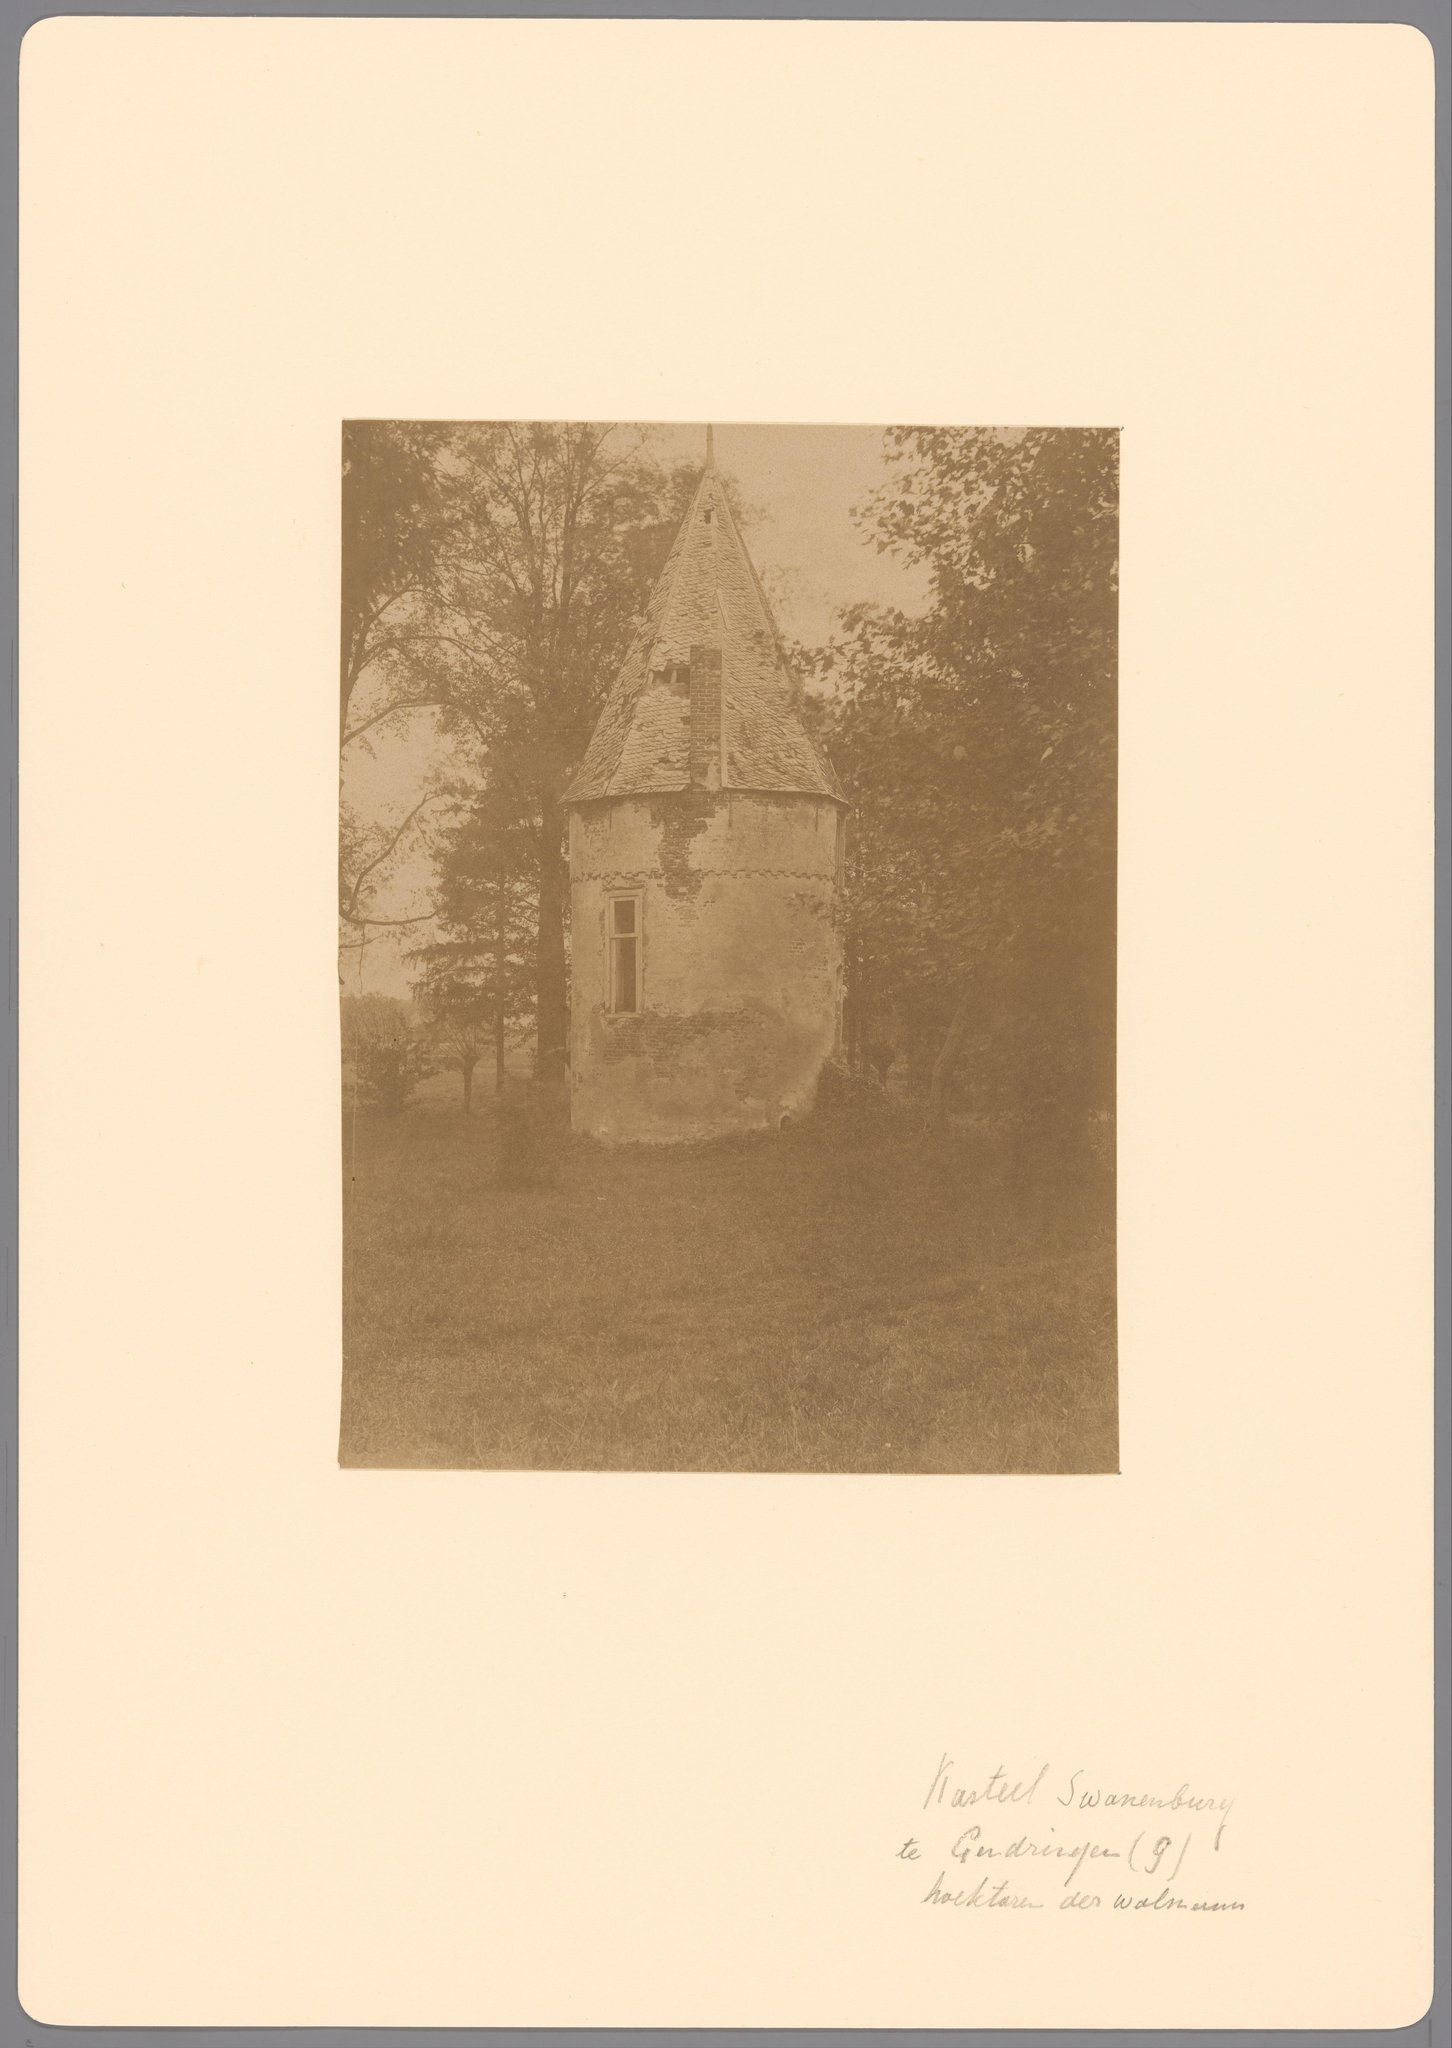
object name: photograph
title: Toren van de walmuur bij Kasteel Zwanenburg te Gendringen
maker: anoniem (monumentenzorg)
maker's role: fotograaf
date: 1890-1900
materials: cardboard, photographic support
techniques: albumen print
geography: gendringen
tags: castle, walls ~ fortified city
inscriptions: annotation: ‘Kasteel Swanenburg/ te Gendringen (G.)/ hoektoren der walmuur’